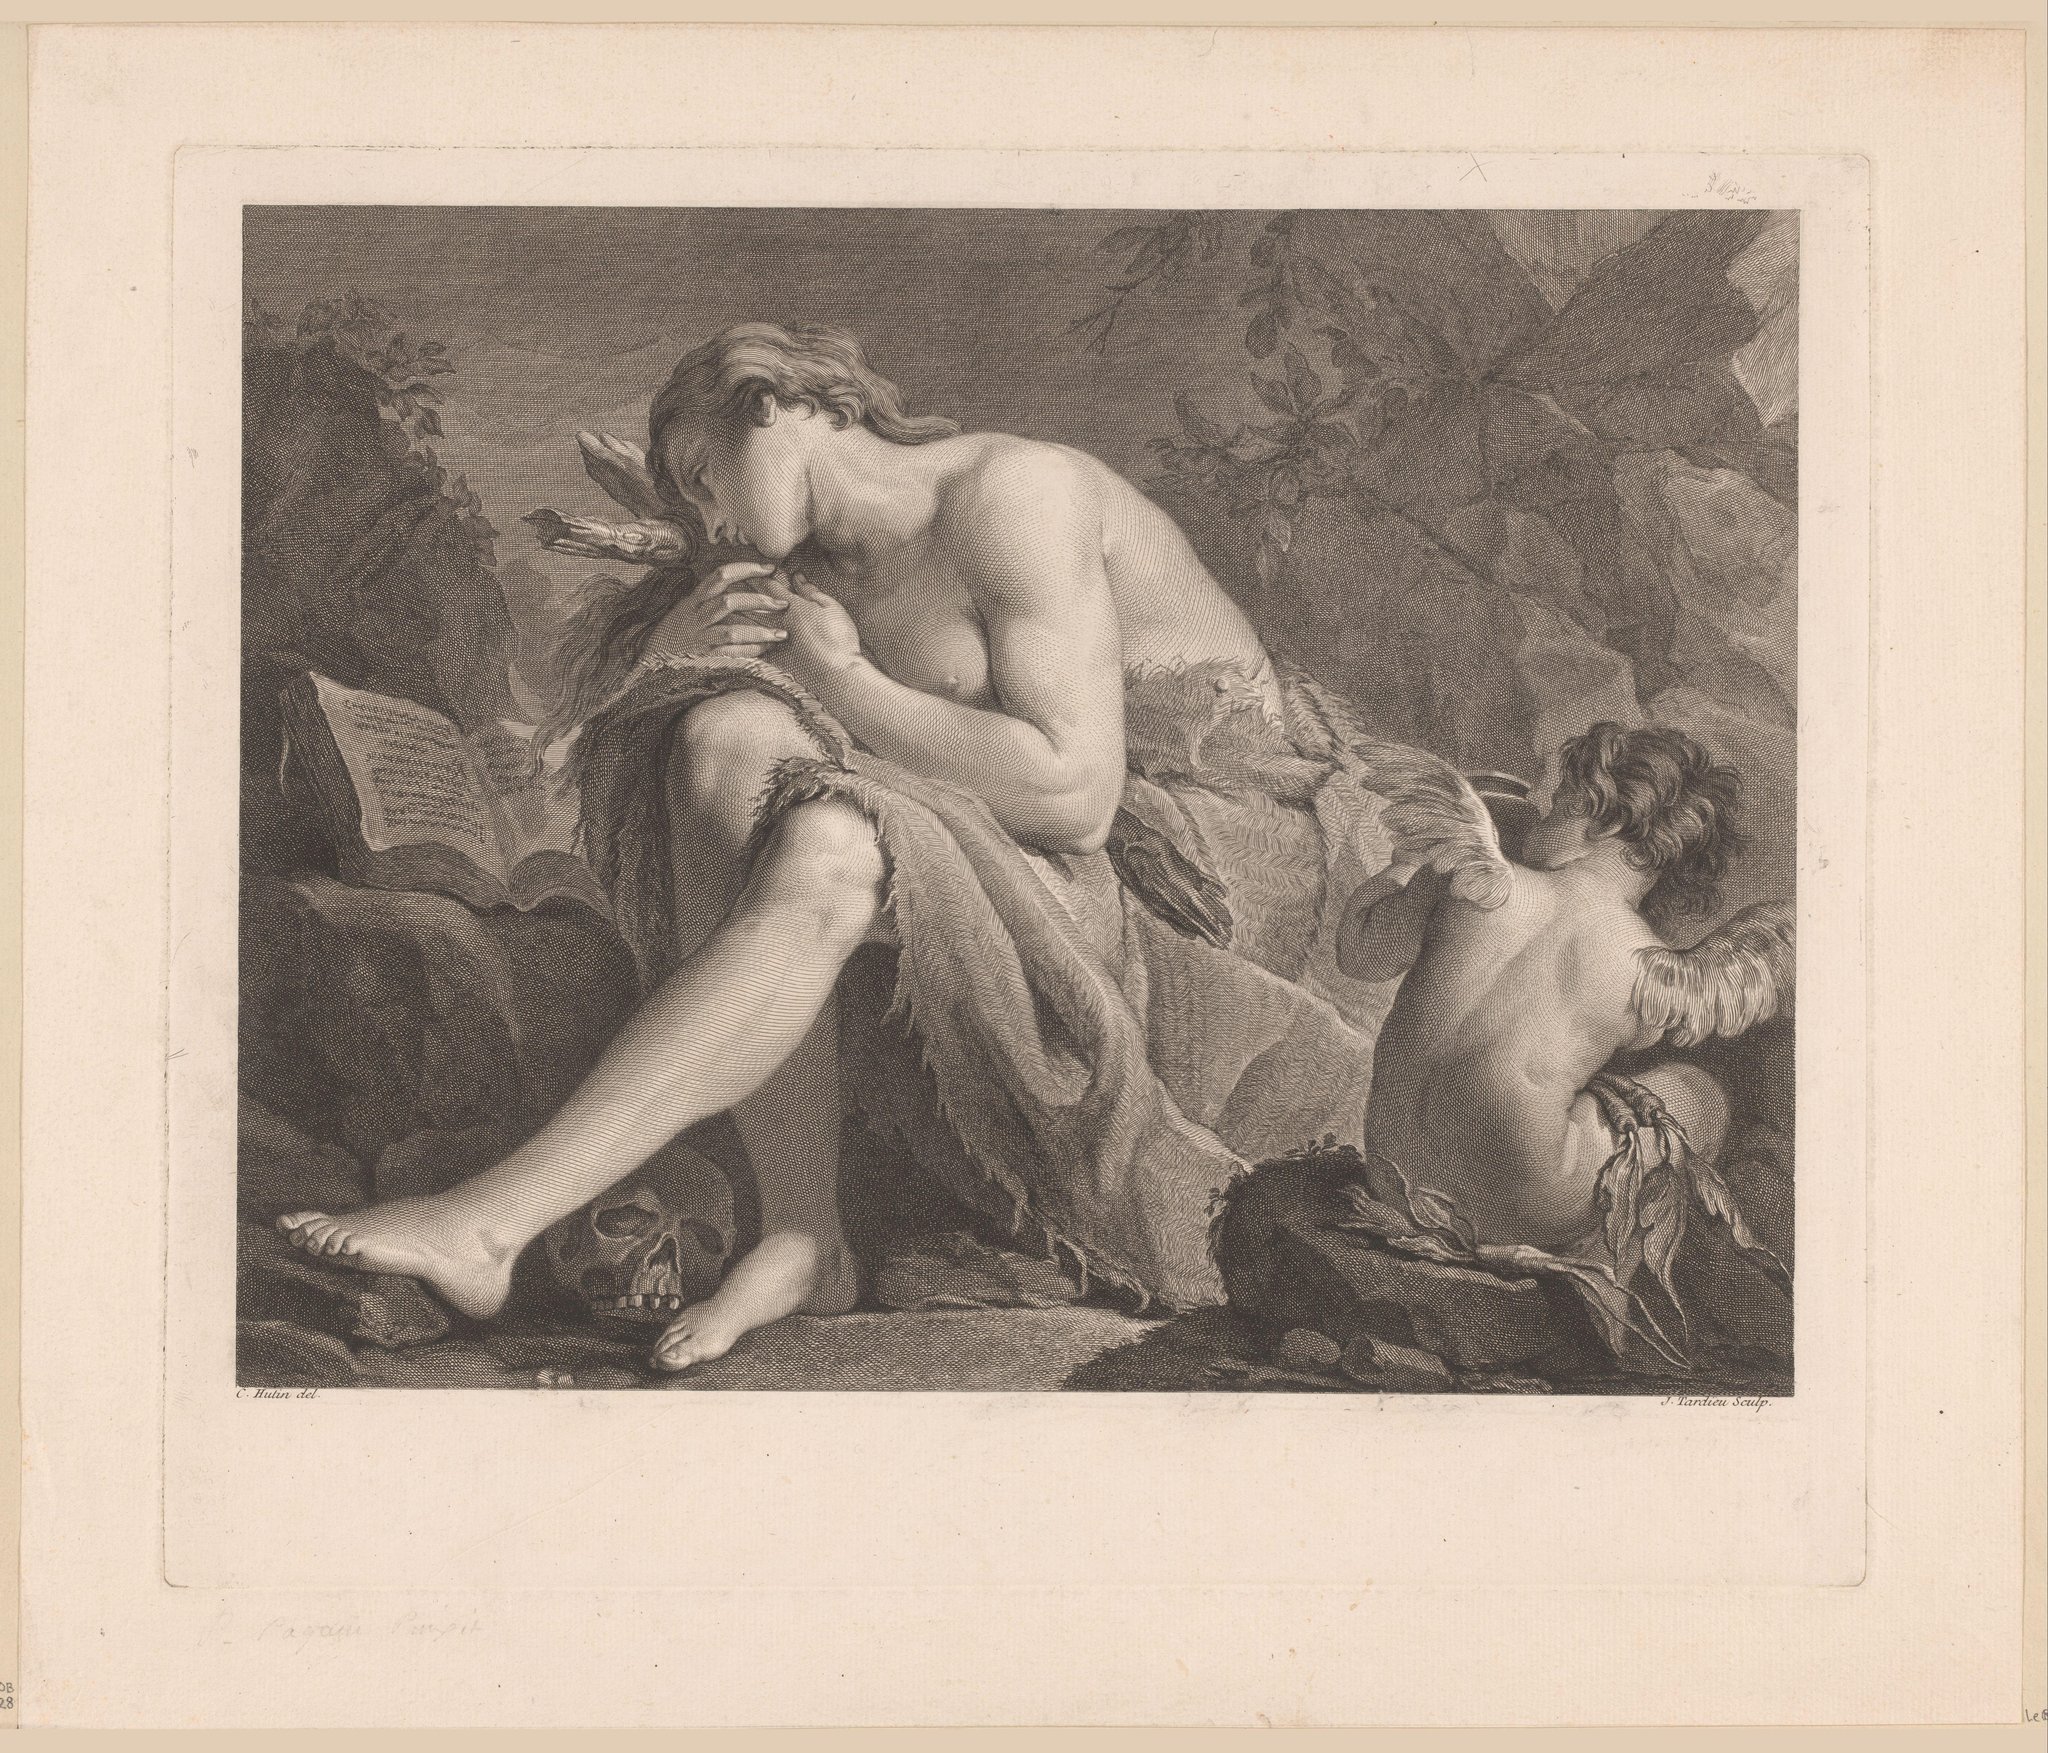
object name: print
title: Maria Magdalena in de wildernis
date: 1726-1791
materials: paper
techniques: engraving, etching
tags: the penitent harlot mary magdalene; possible attributes: book (or scroll), crown, crown of thorns, crucifix, jar of ointment, mirror, musical instrument, palm-branch, rosary, scourge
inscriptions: collector's mark: Lugt 240